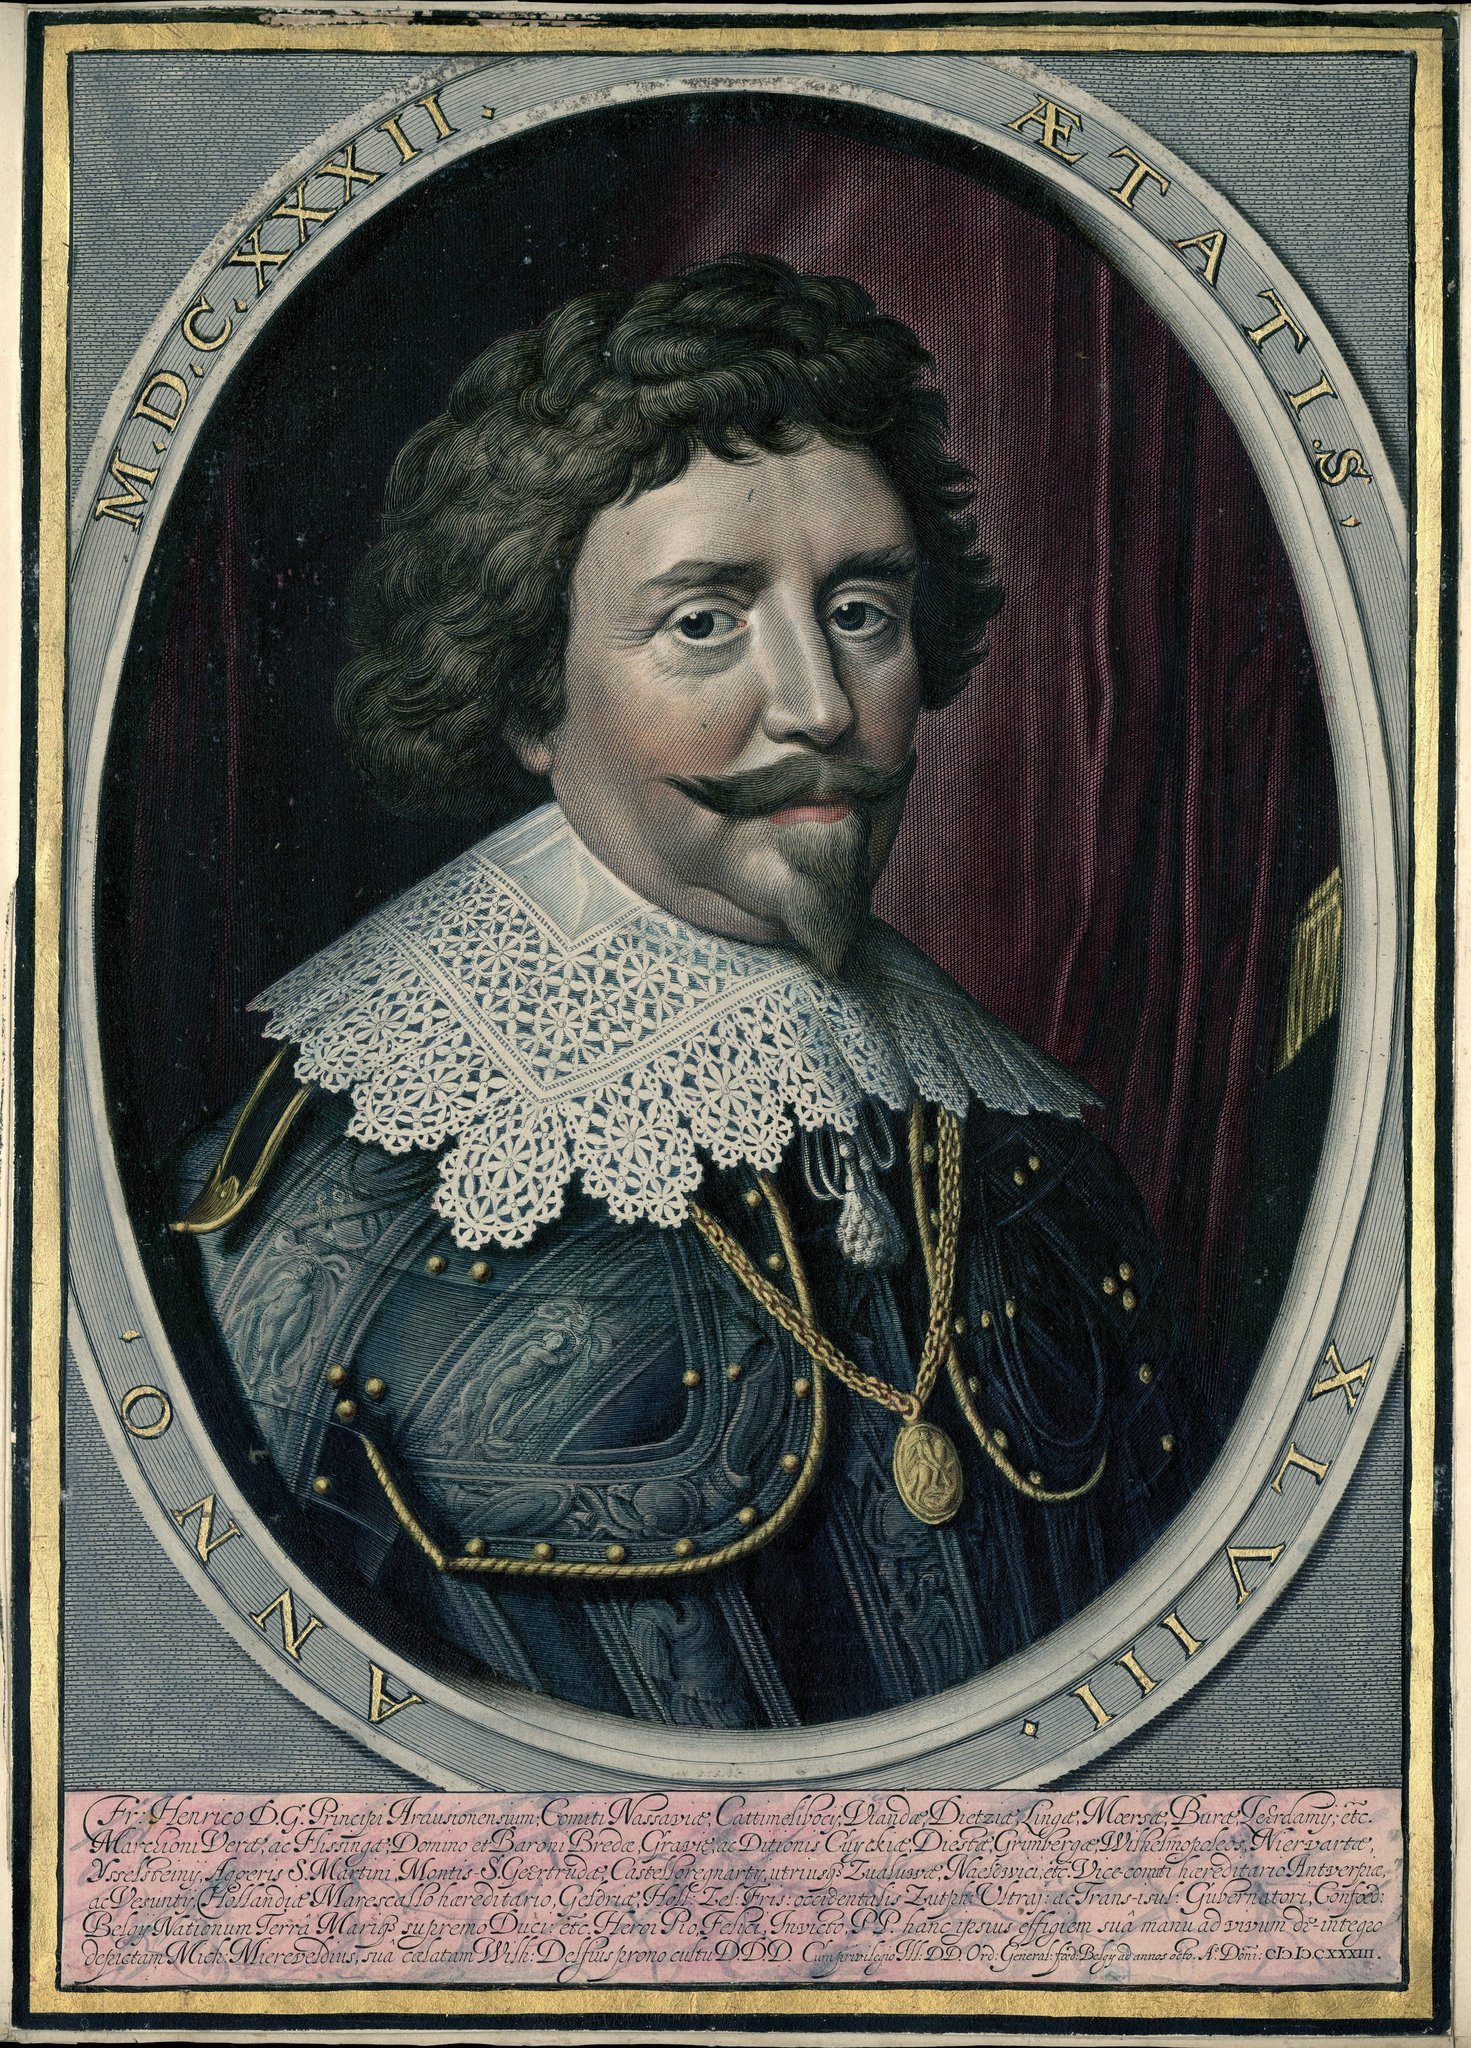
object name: book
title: Portret van Frederik Hendrik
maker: willem jacobsz delff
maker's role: draughtsman, print maker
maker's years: 1580-1638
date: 1632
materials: paint, paper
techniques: colour, engraving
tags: the hague, frederick henry (prince of orange)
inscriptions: date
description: Ingekleurde portret van Frederik Hendrik. Opgezet op een blad papier in een lijst versierd met goud en ingeplakt in de luxe editie uit ca. 1755 van het boek 'Begraeffenisse van syne hoogheyt Frederick Henrick' van Pieter Post, uitgegeven te Amsterdam in 1651.